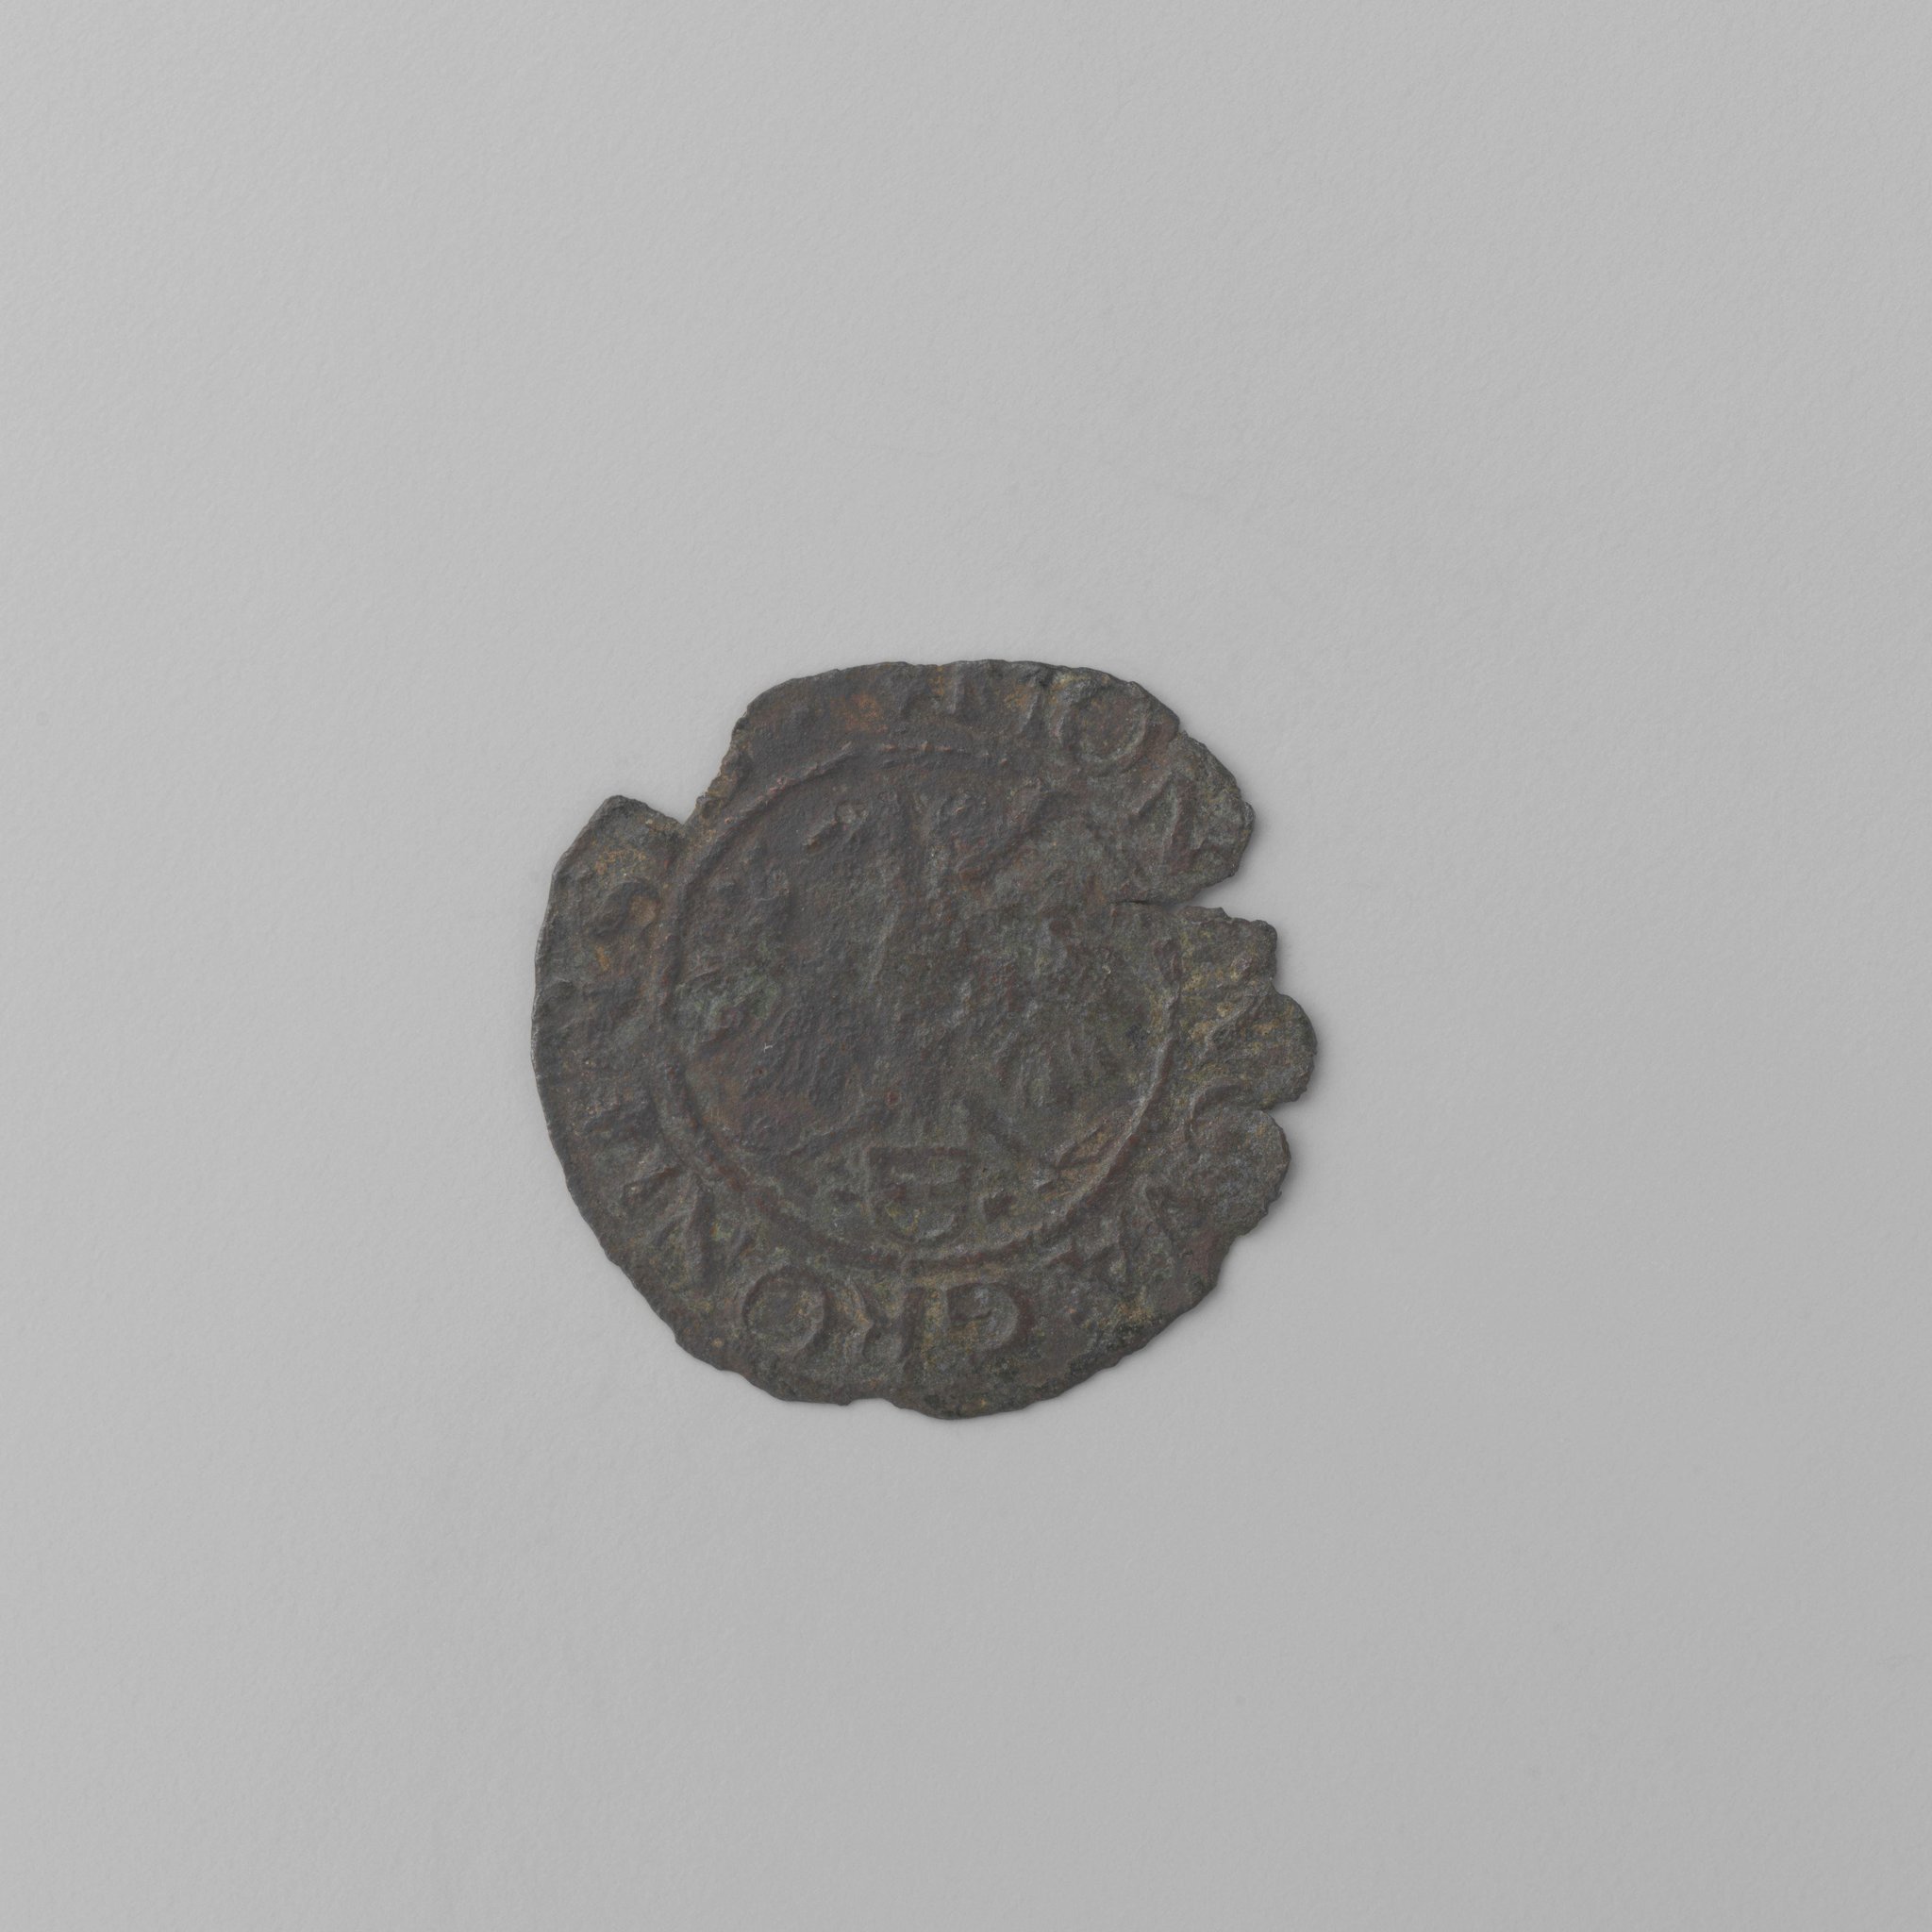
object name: coin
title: Groningen, plak, 1591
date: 1591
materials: copper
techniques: striking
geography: groningen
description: Zilver-koperen munt. Voorzijde: dubbelkoppige adelaar, waaronder wapenschild. Keerzijde: op lang gebloemd kruis wapenschild in vierpas. Jaartal in omschrift.